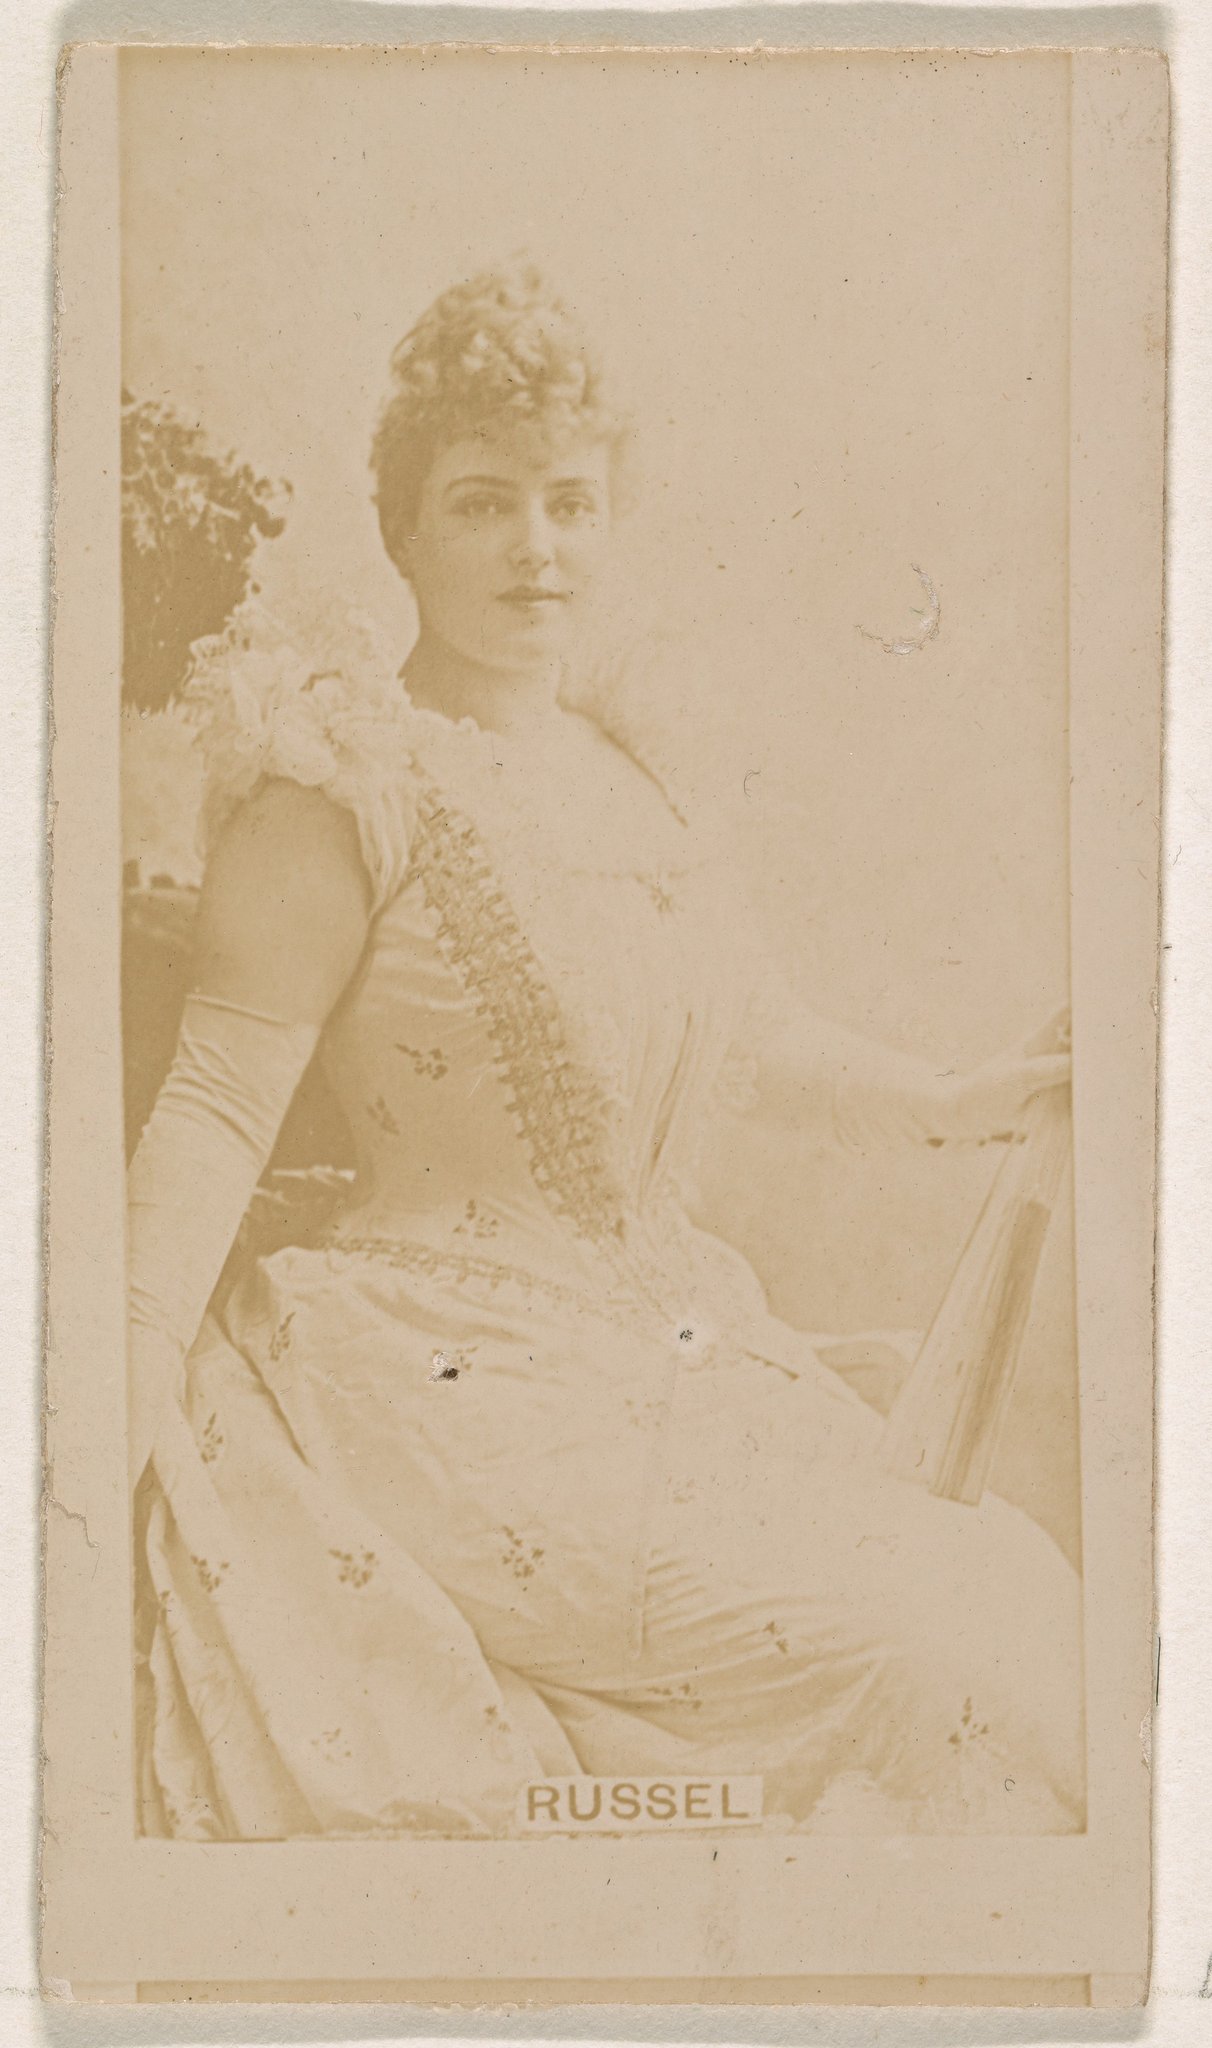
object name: photograph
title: Russell, from the Actresses series (N245) issued by Kinney Brothers to promote Sweet Caporal Cigarettes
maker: kinney brothers tobacco company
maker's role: publisher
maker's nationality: american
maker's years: 1869-2011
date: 1890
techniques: albumen silver print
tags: portraits,women,actresses